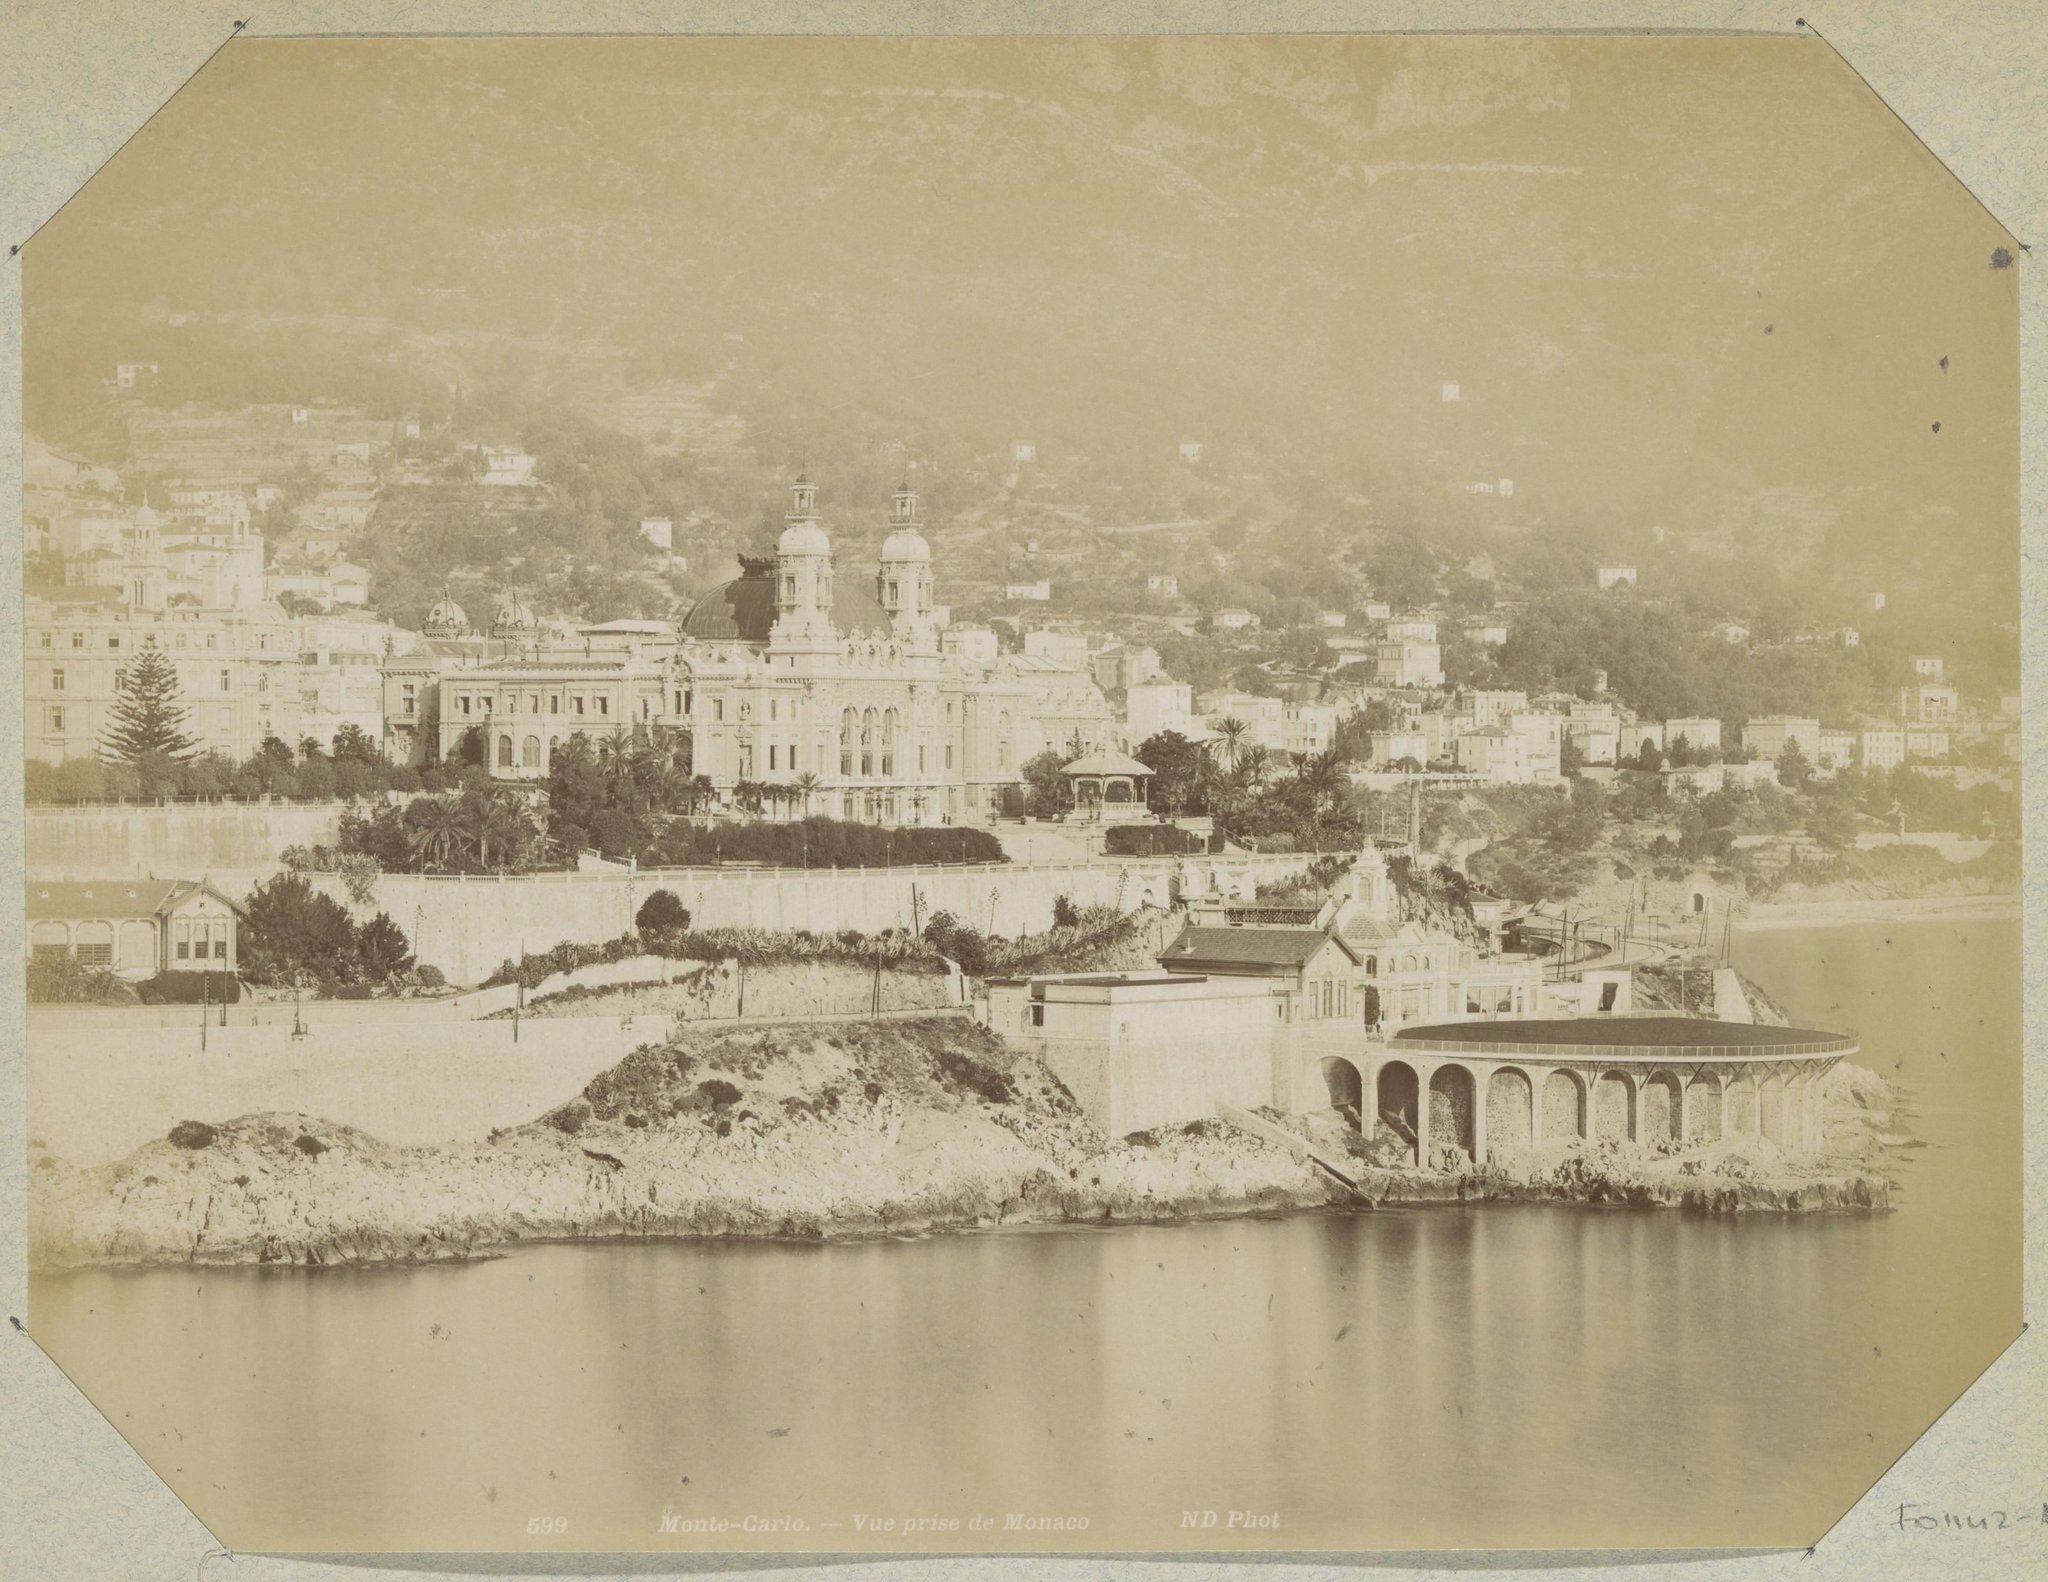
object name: photograph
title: Gezicht op Monte Carlo vanaf Monaco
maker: étienne neurdein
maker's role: publisher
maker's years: 1832-1918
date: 1890-1900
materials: paper, photographic support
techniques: albumen print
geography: monaco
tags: prospect of village, silhouette of village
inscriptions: negative number: ‘599’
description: Onderdeel van Album van een Franse amateur met foto's van Frankrijk, Algerije, Palmyra, de Wereldtentoonstelling van 1900 en van bekende Fransen.